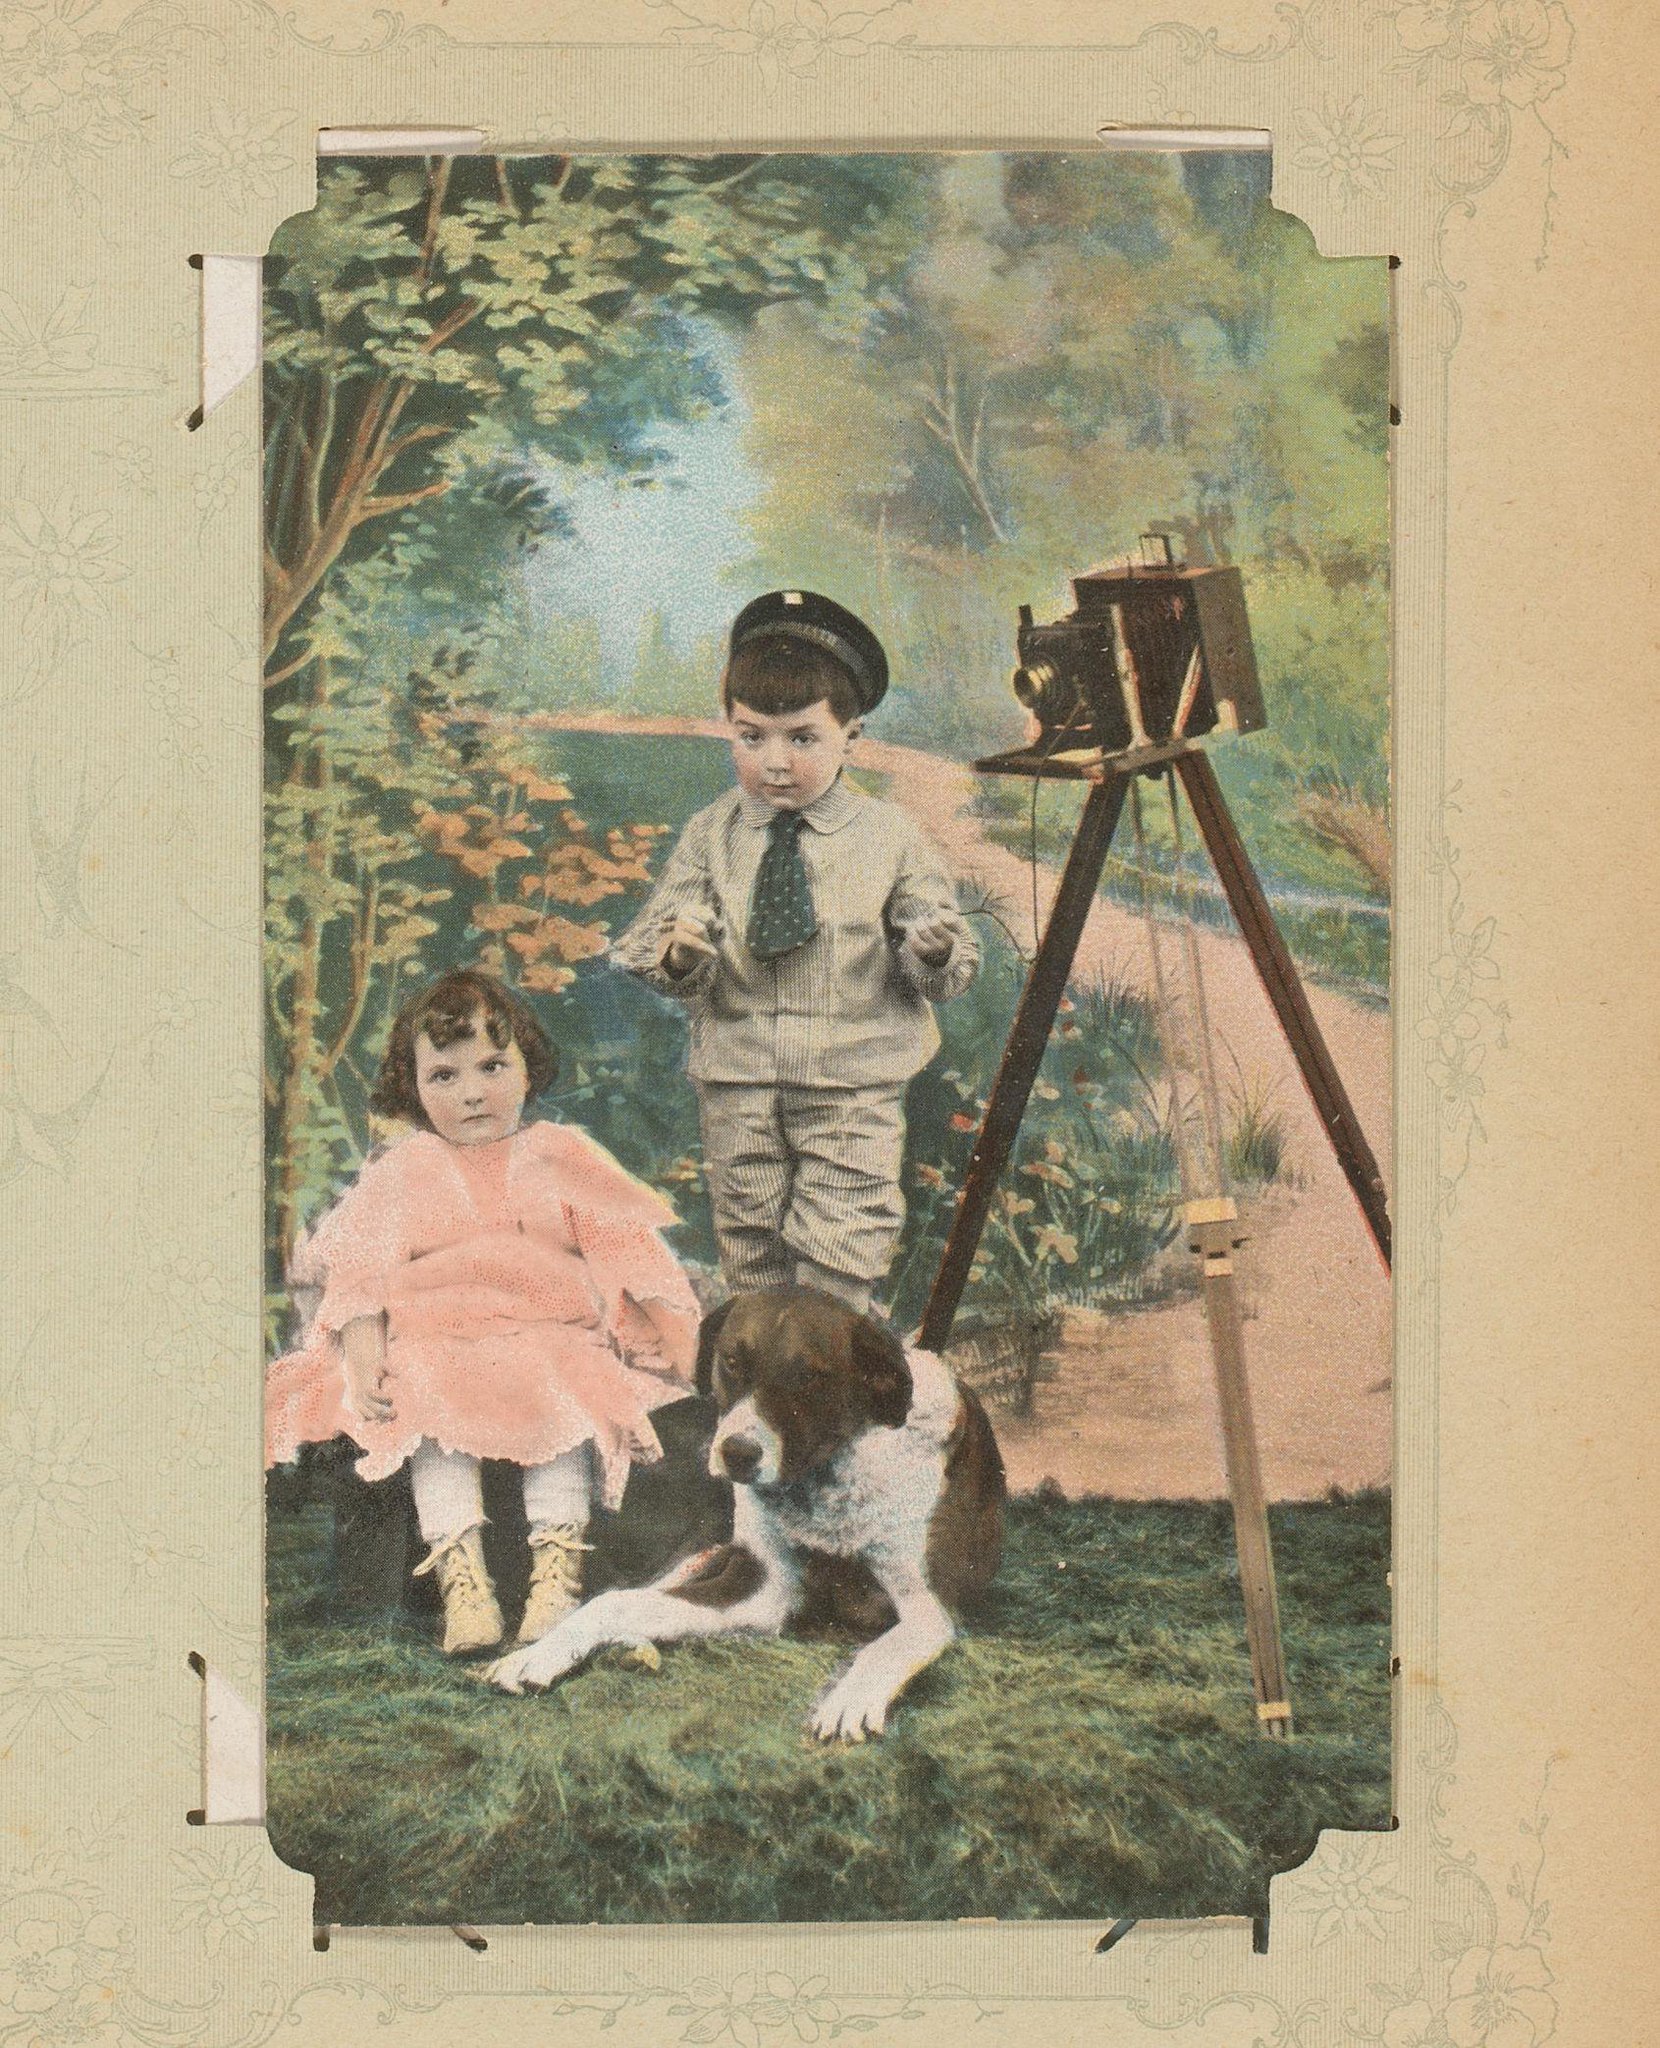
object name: album leaf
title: Jongen en meisje met een hond en camera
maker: Anonymous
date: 1900-1950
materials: cardboard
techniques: chromolithography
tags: boy (child between toddler and youth), taking photographs, girl (child between toddler and youth), dog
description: Deze prent maakt deel uit van een album.